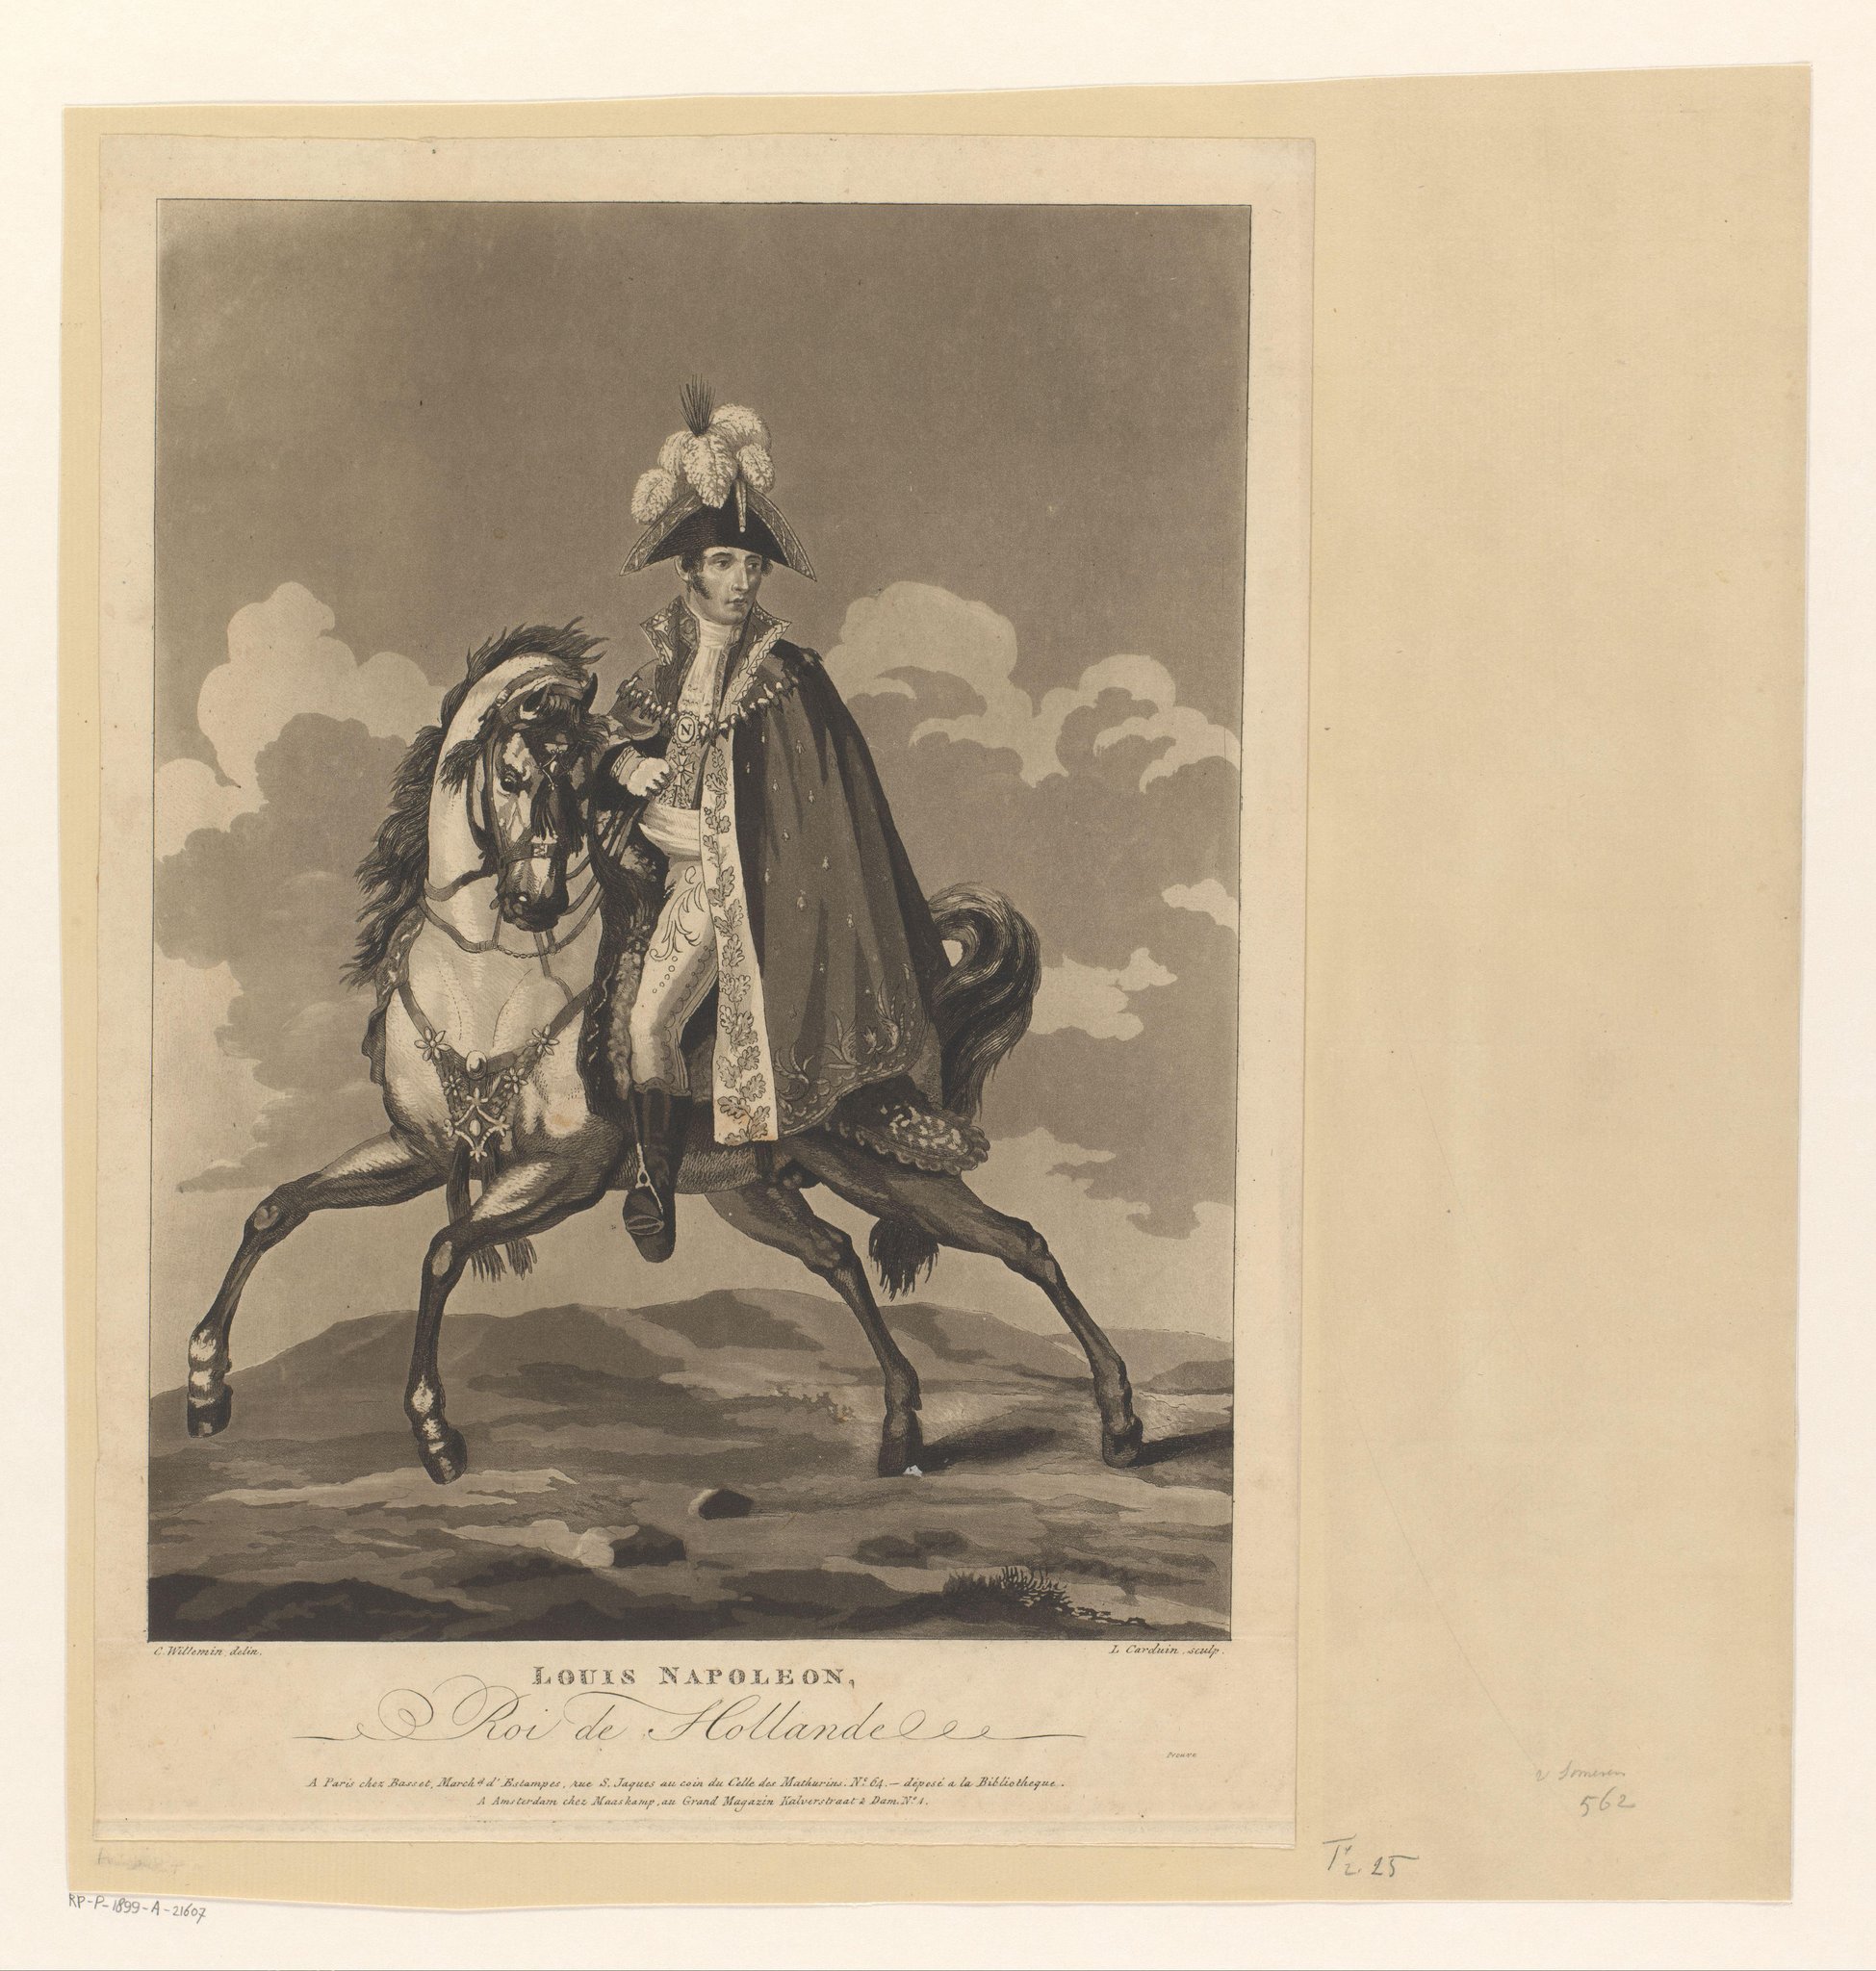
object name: print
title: Portret van Lodewijk Napoleon Bonaparte te paard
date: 1785-1819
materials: paper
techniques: aquatint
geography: paris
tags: louis napoleon (king of holland), equestrian state-portrait, historical persons, king, holland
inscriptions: inscription: ‘8 Dl: Bloz 504. P 29. Bloz 419.’